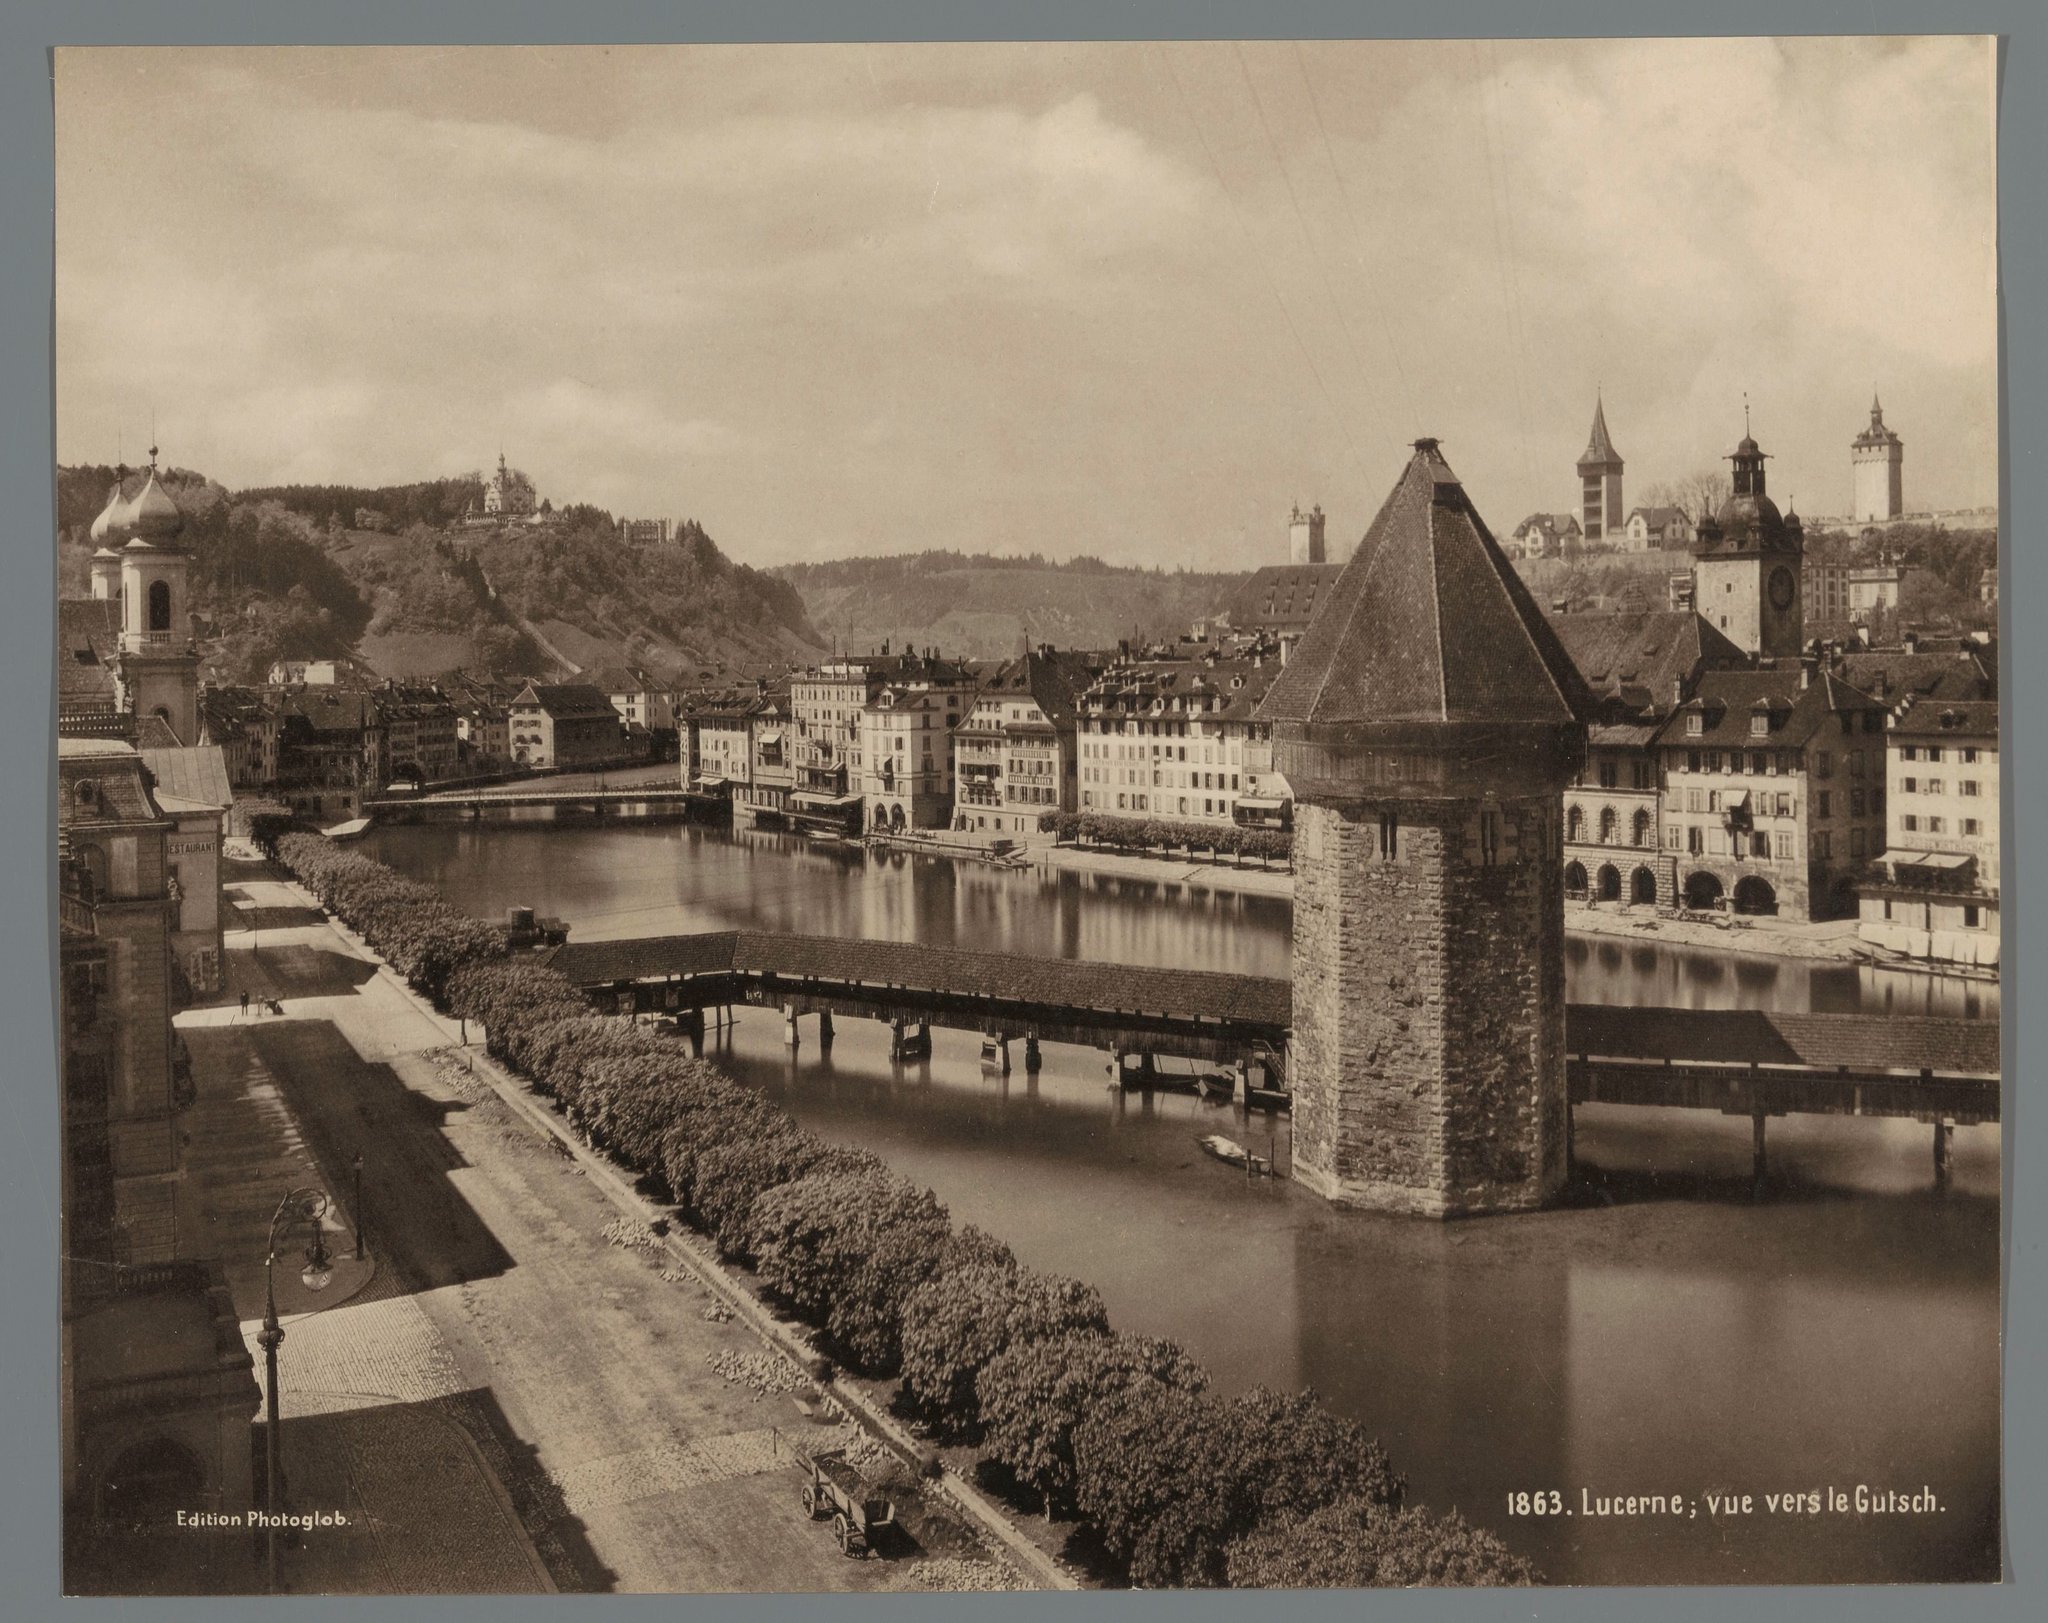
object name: photomechanical print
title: Lucerne, vue vers le Gutsch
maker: Anonymous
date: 1895-1930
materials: paper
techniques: photograph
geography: zurich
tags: palace, bridge in city across river, canal, etc.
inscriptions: number: ‘1863.’